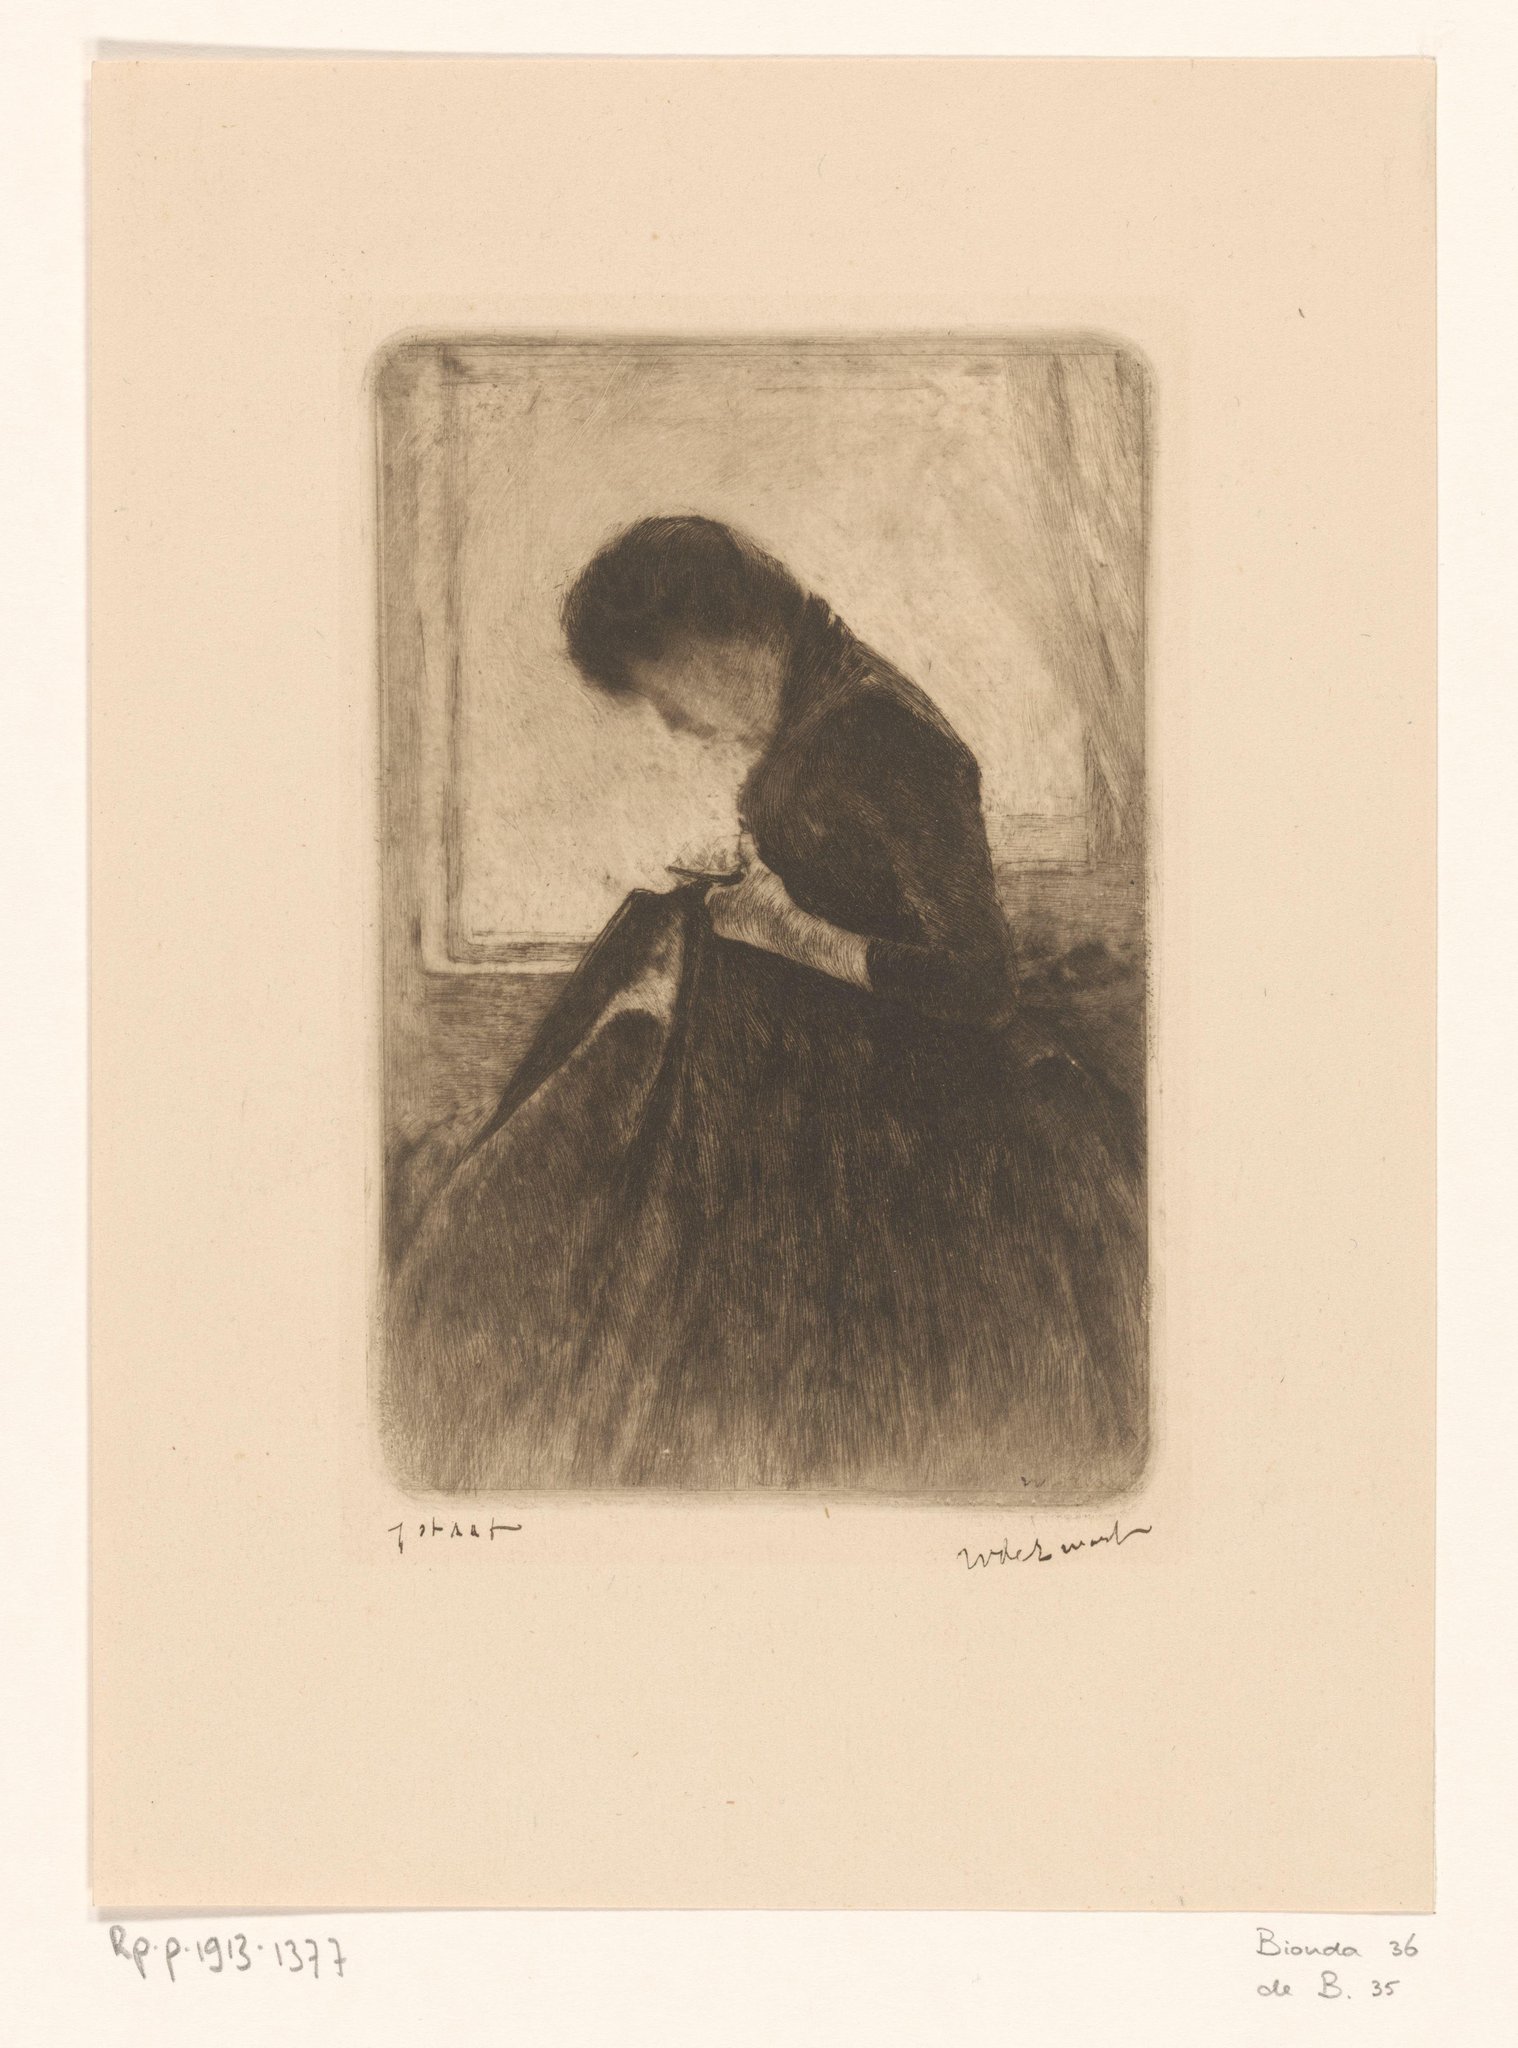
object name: print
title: Zittende vrouw naaiend bij het venster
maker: willem de zwart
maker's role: draughtsman, painter, print maker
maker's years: 1862-1931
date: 1888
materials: paper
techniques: drypoint, intaglio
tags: adult woman, closed window, sewing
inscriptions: collector's mark: Lugt 2233